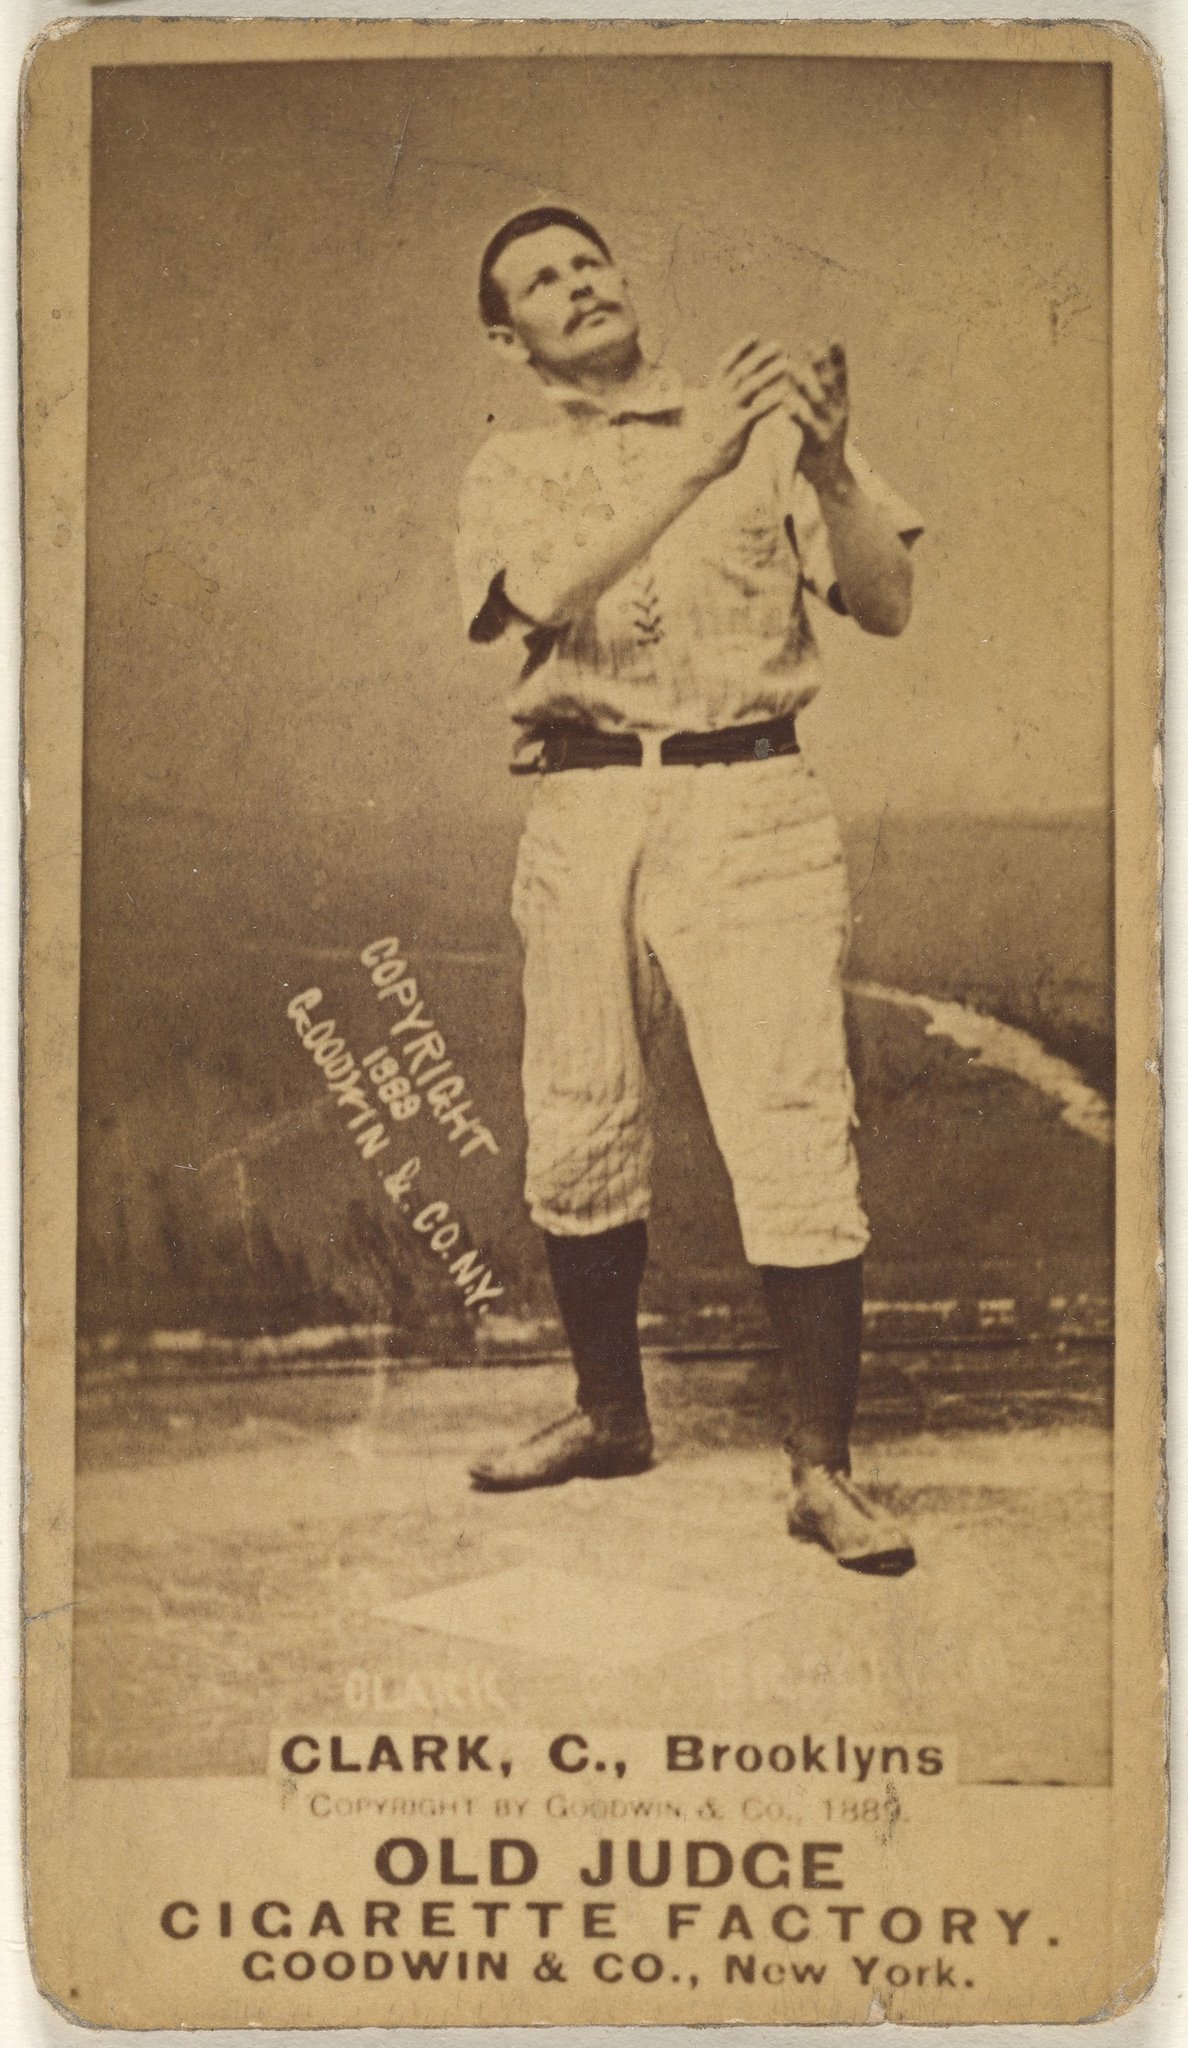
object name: baseball card, photograph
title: Clark, Catcher, Brooklyn Bridegrooms, from the Old Judge series (N172) for Old Judge Cigarettes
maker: goodwin & company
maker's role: publisher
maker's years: 1850-1950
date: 1889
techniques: albumen silver print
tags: men,portraits,baseball,athletes